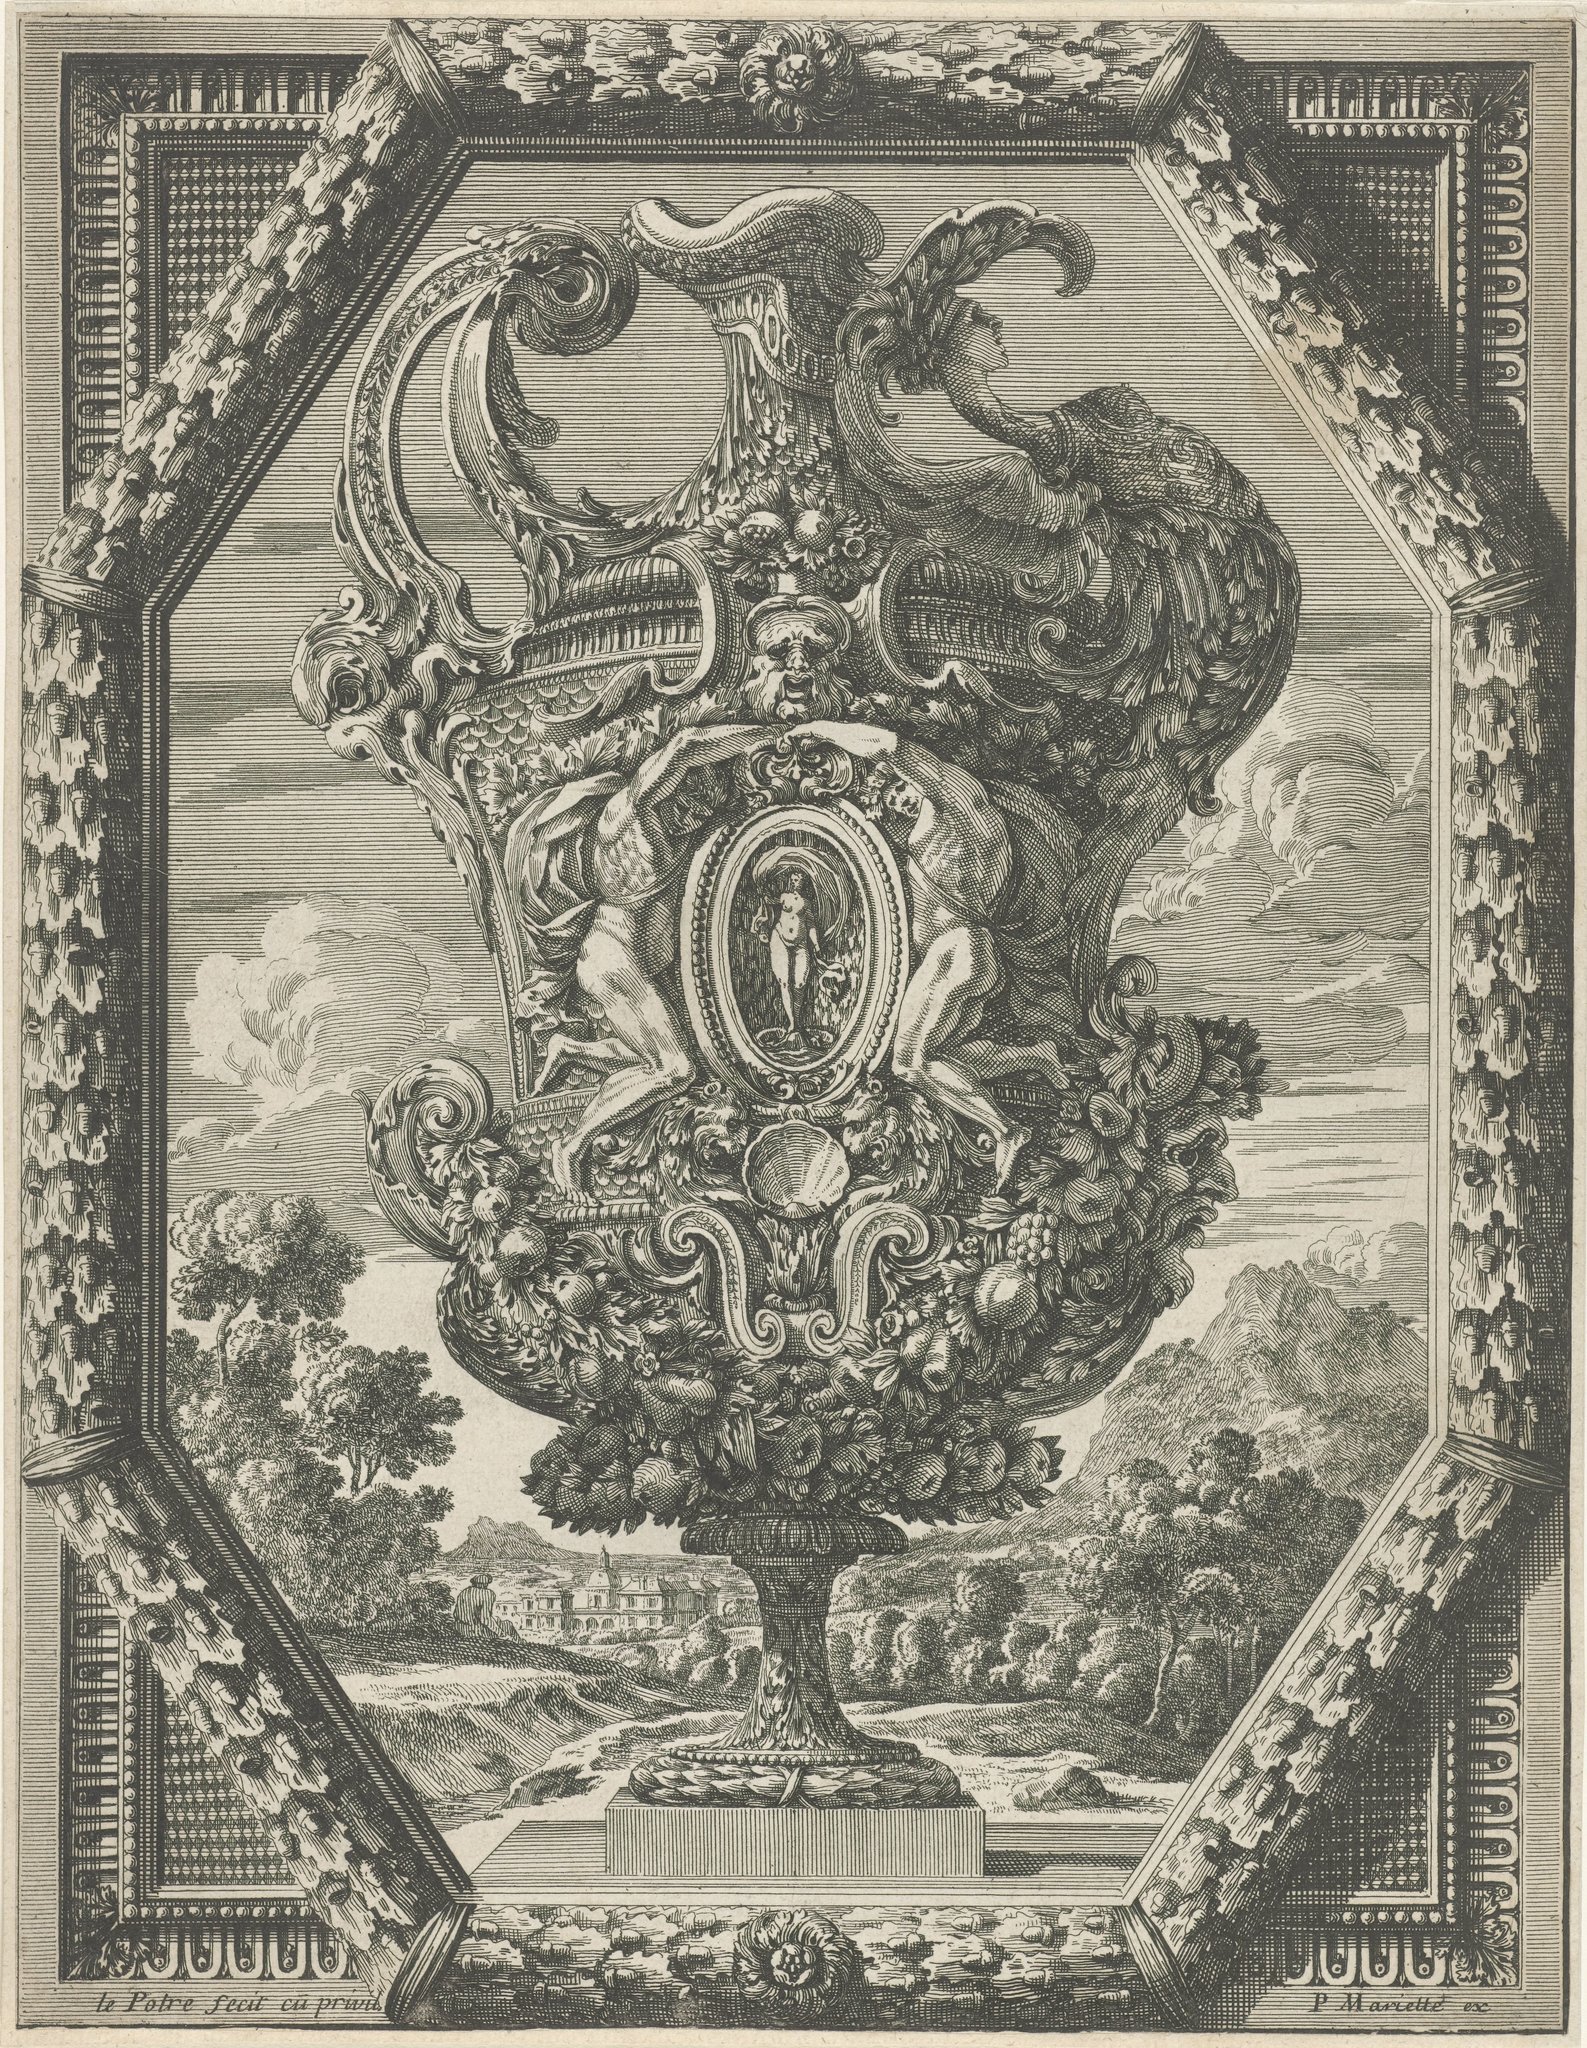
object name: ornament print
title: Schenkkan met naakte jongelingen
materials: paper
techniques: etching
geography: france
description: In het midden staat Venus op een ovaal medaillon. Blad 3 uit serie van 6 bladen, derde editie.